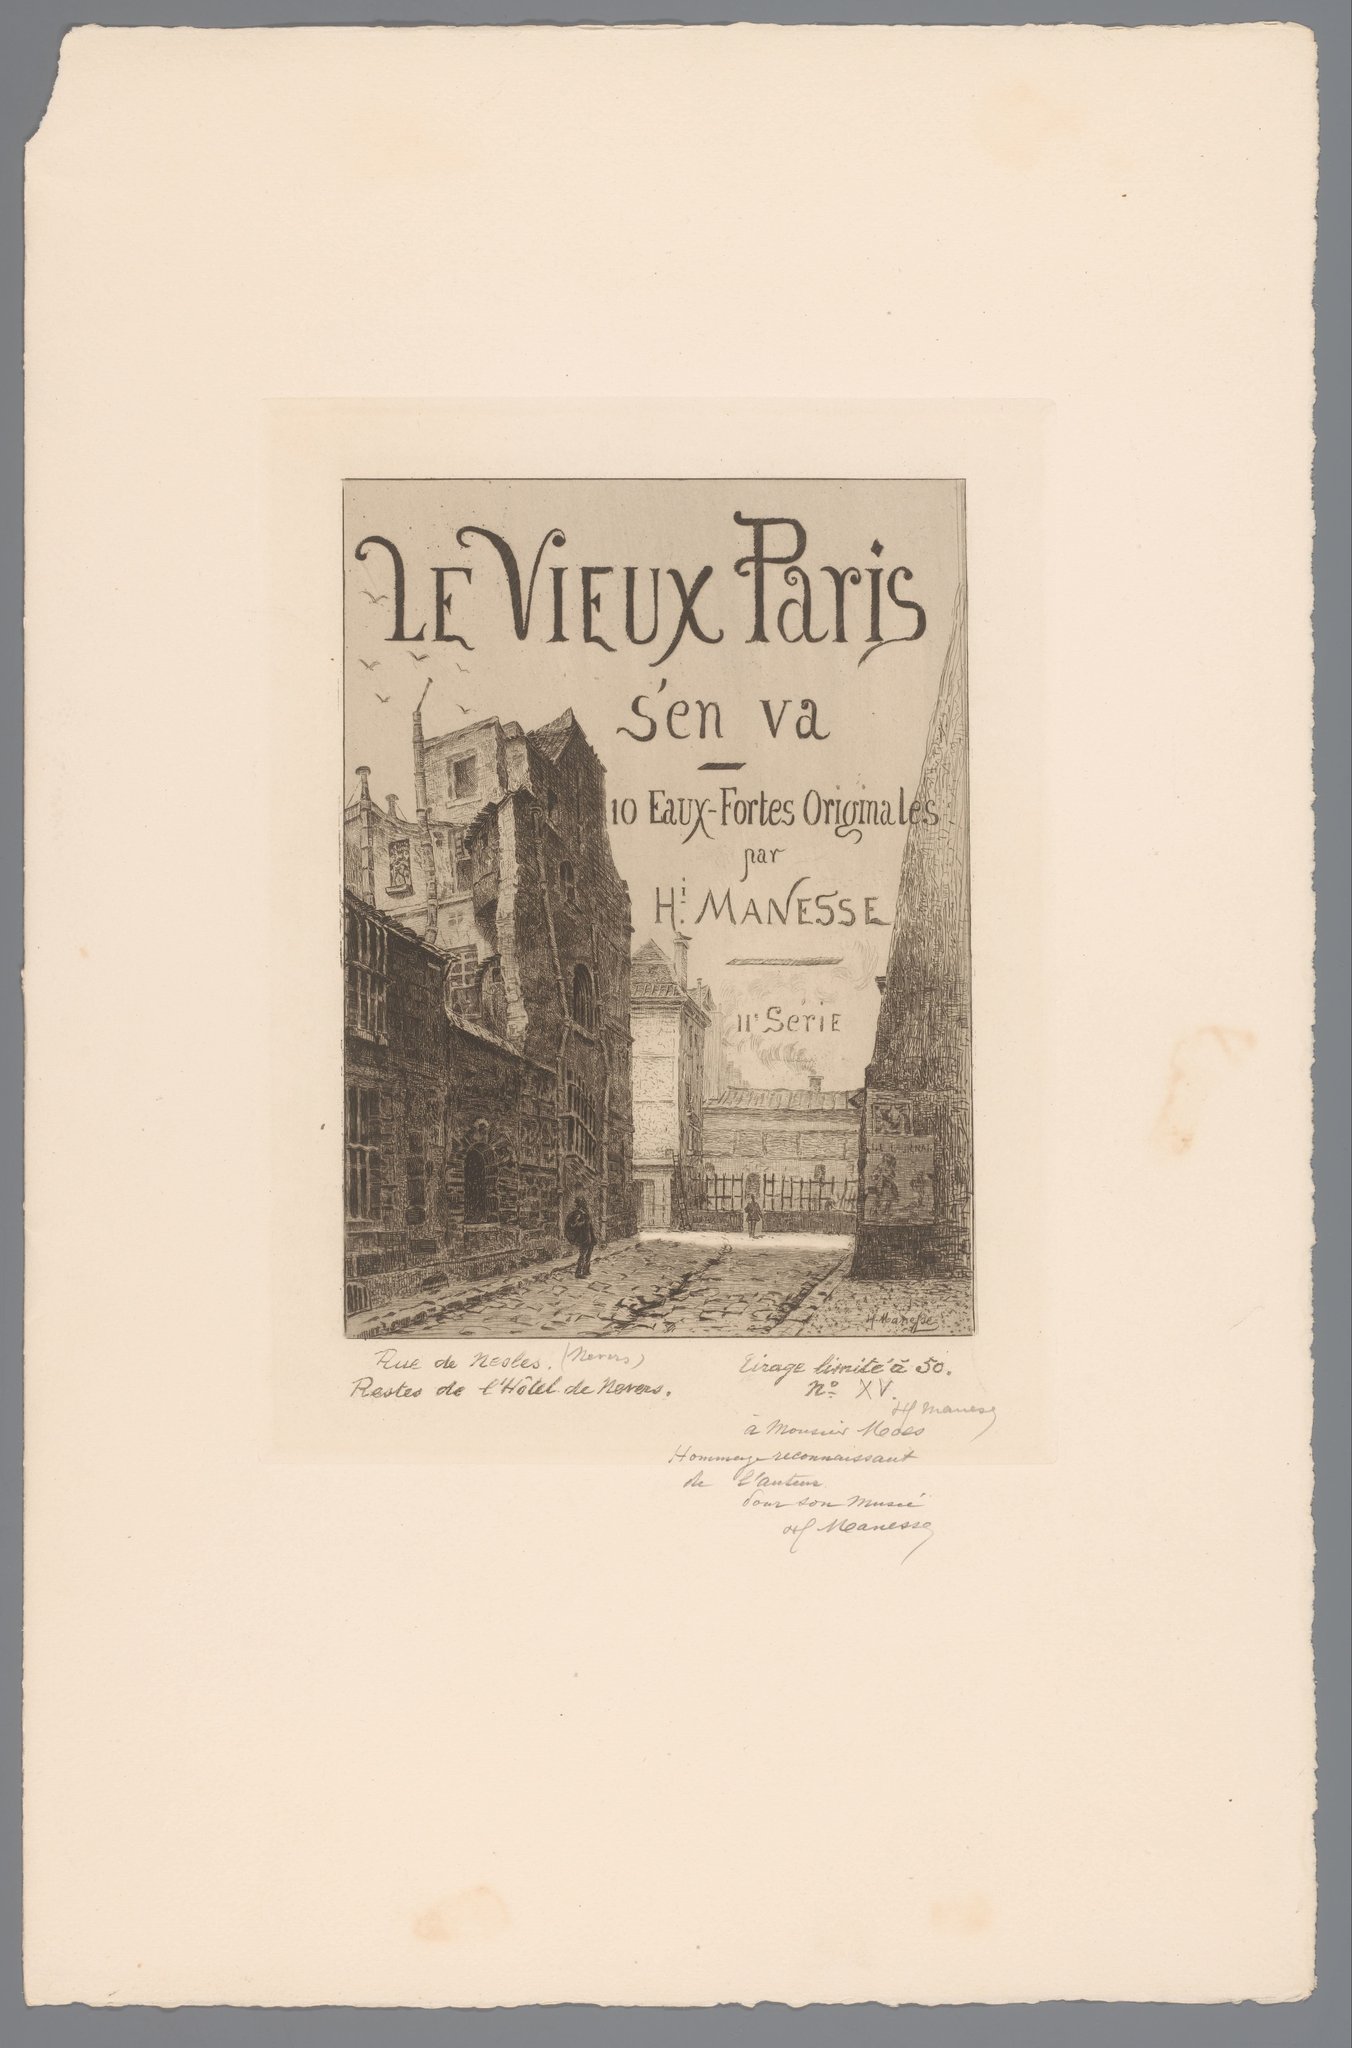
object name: print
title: Titelprent met gezicht op de rue de Nesle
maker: henri manesse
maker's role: print maker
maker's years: 1854-1940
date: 1906-1911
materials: paper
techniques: drypoint, engraving, etching, intaglio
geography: france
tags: street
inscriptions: dedication: ‘À Monsieur Moes Hommage reconnaissant de l'auteur Pour son Musée/ H Manesse’, collector's mark: Lugt 2228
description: Dit is de elfde serie uit een prentreeks die uit minstens elf series bestaat.